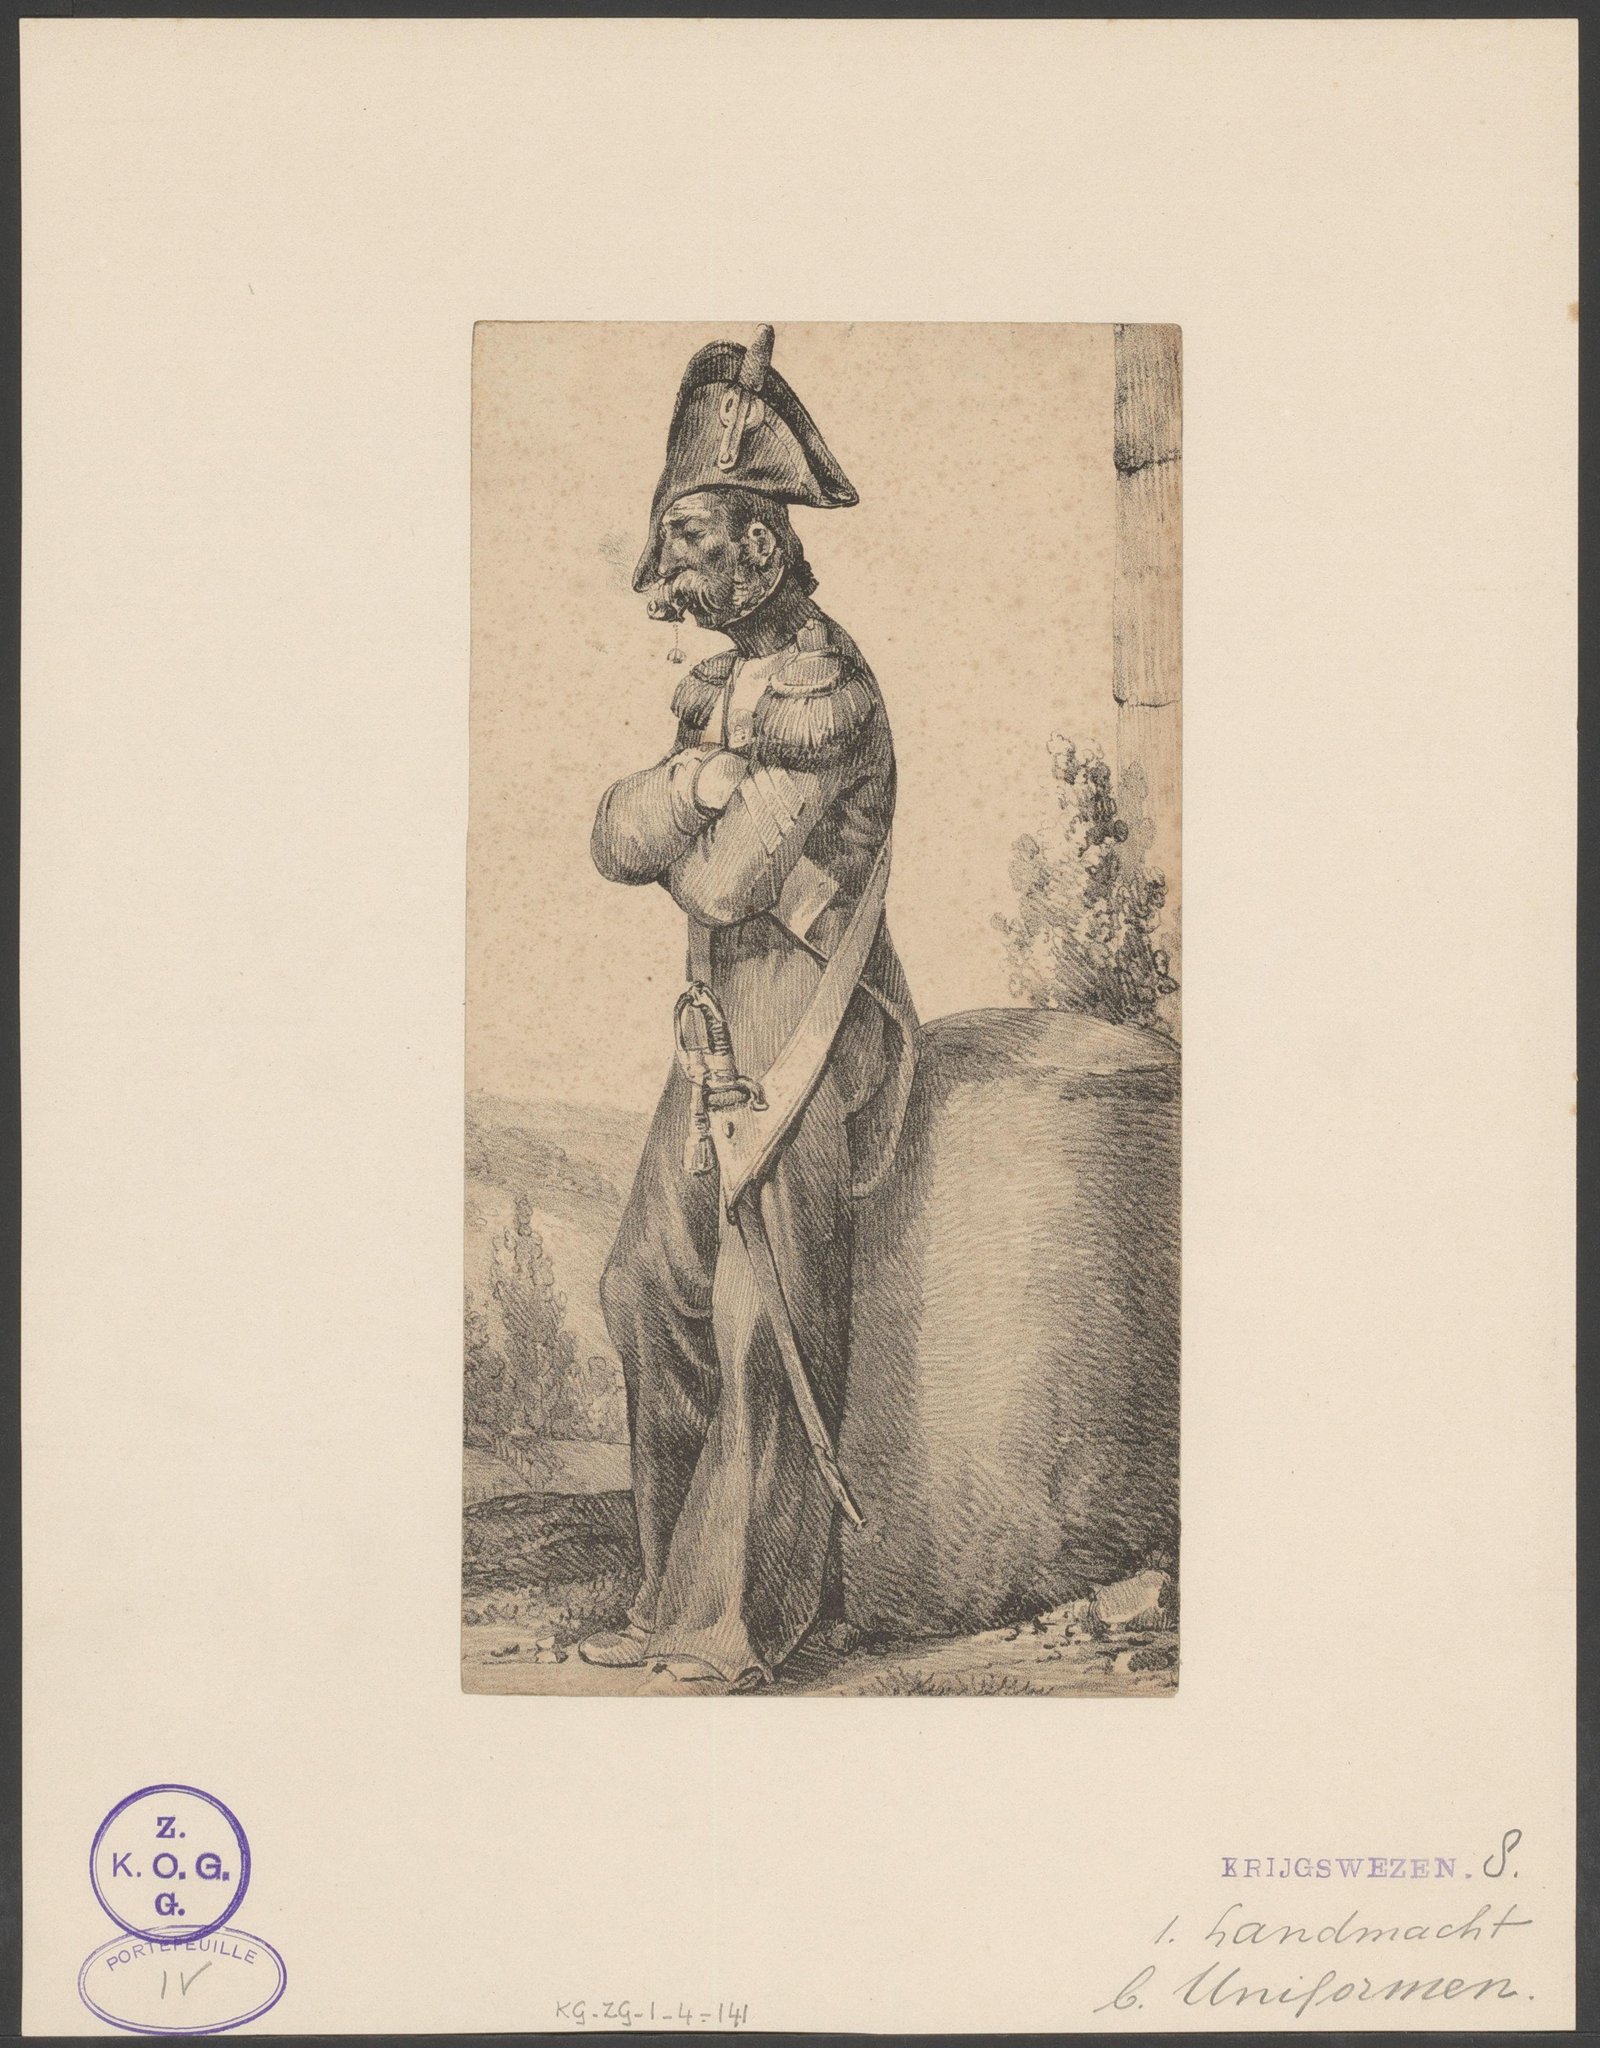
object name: print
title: Staande rustende militair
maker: Anonymous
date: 1800-1899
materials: paper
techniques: lithograph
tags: arms folded over the abdomen, pipe ~ tobacco, (military) uniforms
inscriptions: collector's mark, collector's mark: Lugt 1641